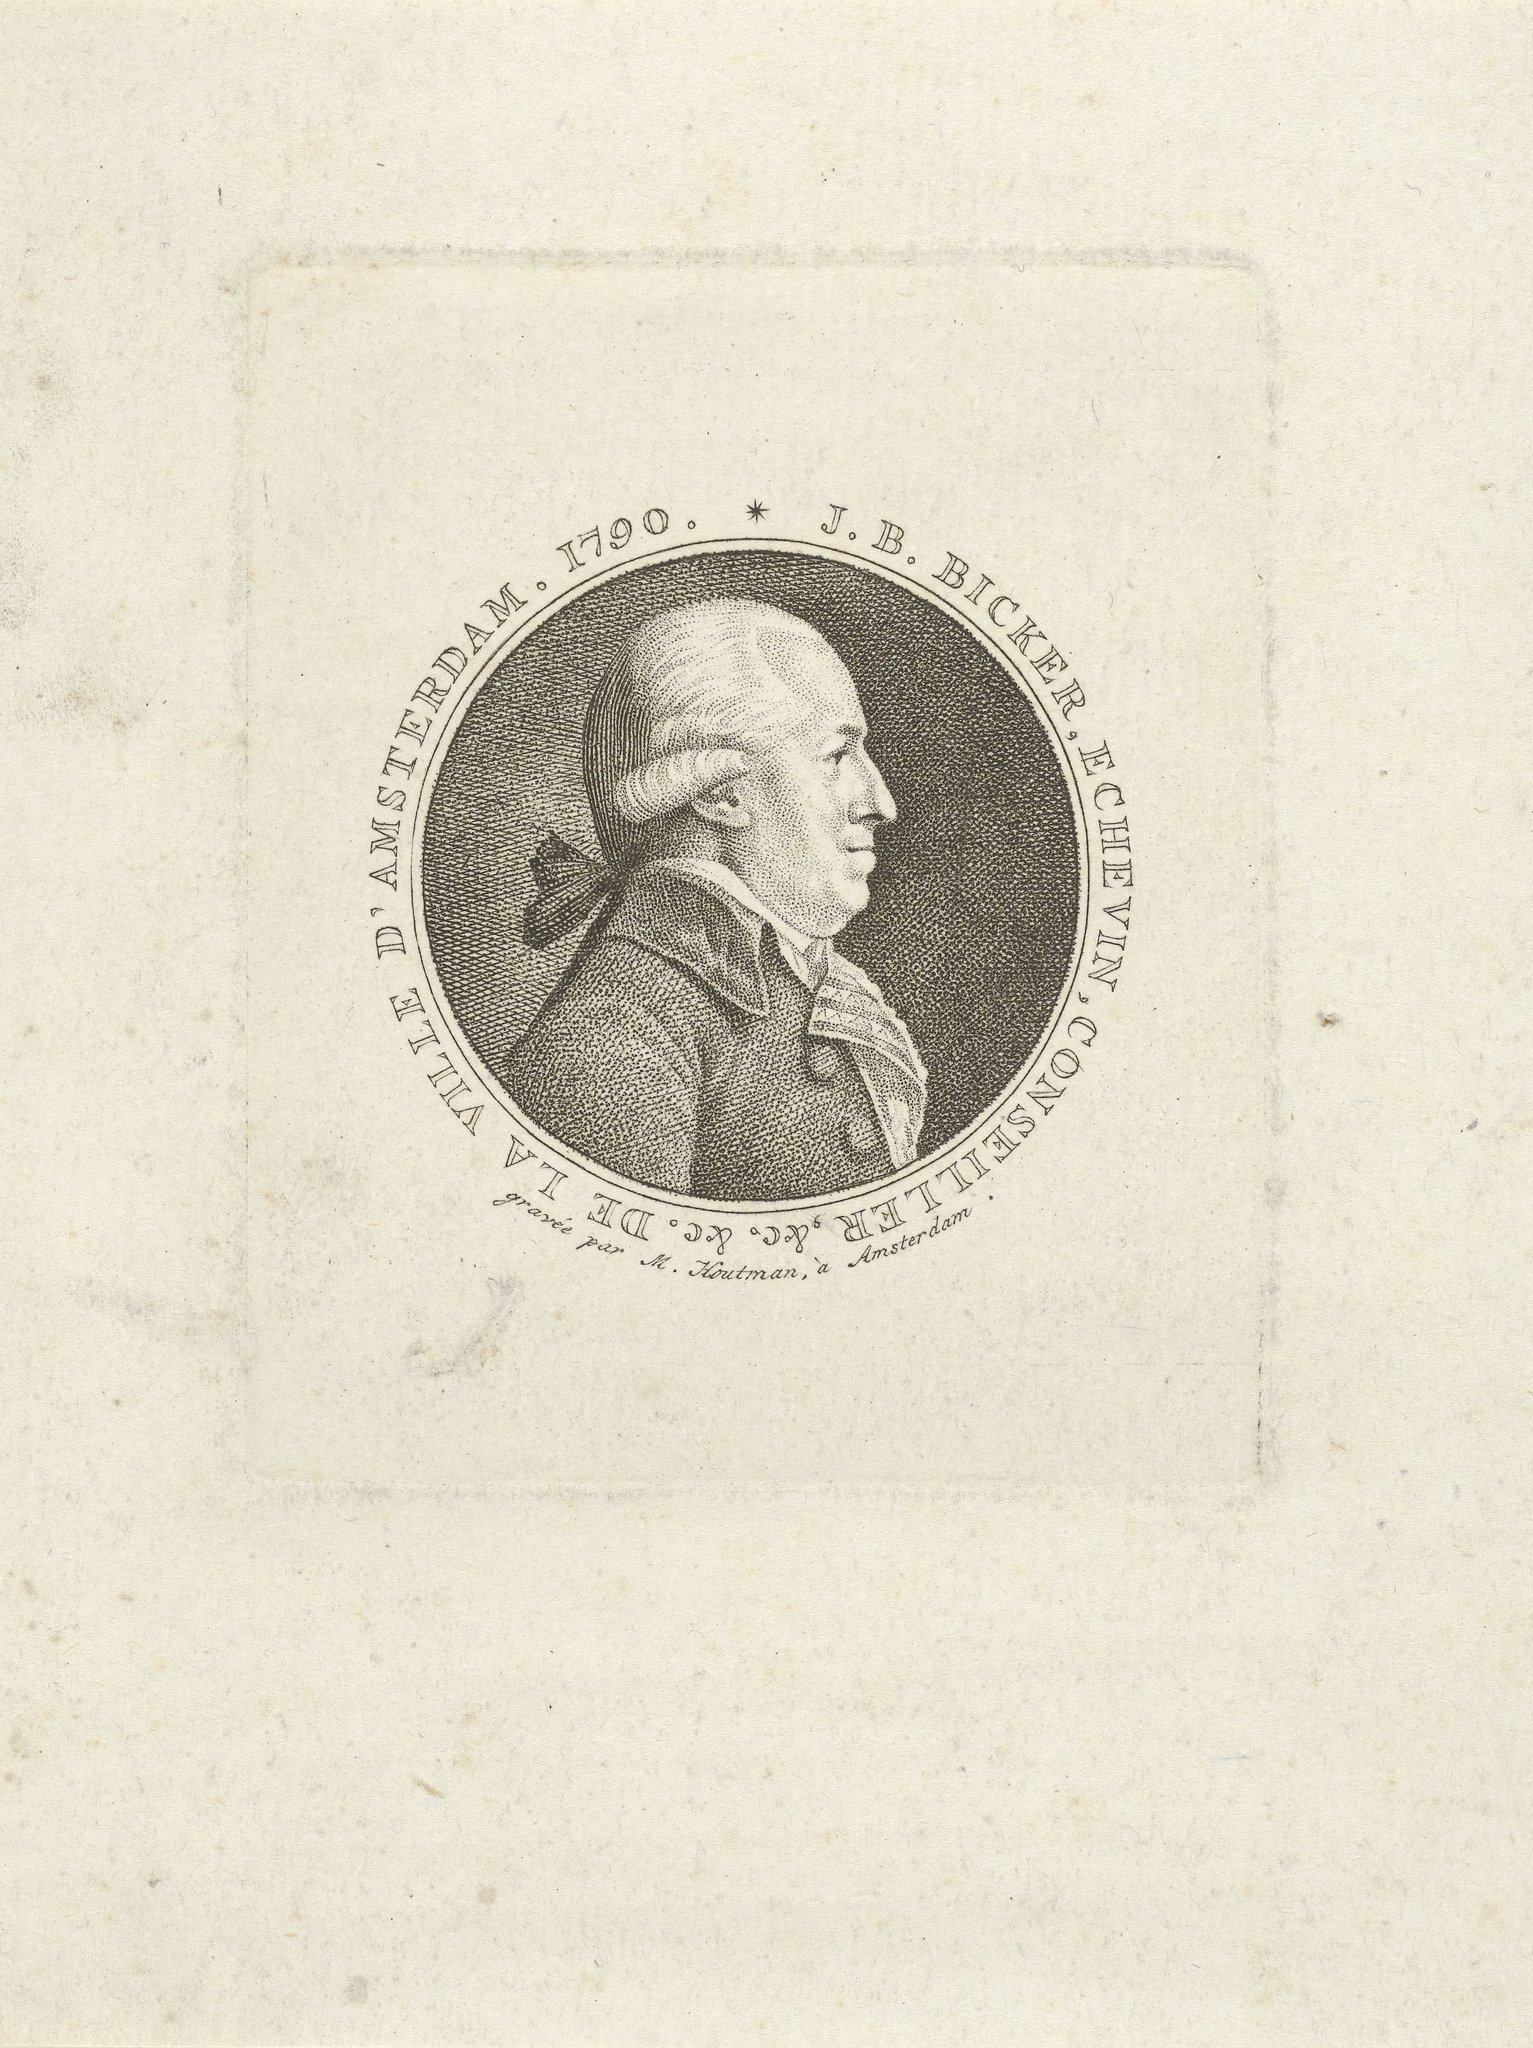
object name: print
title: Portret van Jan Bernd Bicker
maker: marten houtman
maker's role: draughtsman, print maker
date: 1790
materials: paper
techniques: engraving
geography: amsterdam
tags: amsterdam, the hague, historical persons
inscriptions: collector's mark: Lugt 2228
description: Portretbuste en profil naar rechts van Jan Bernd Bicker in een medaillon. Rondom het medaillon een opschrift in het Frans.